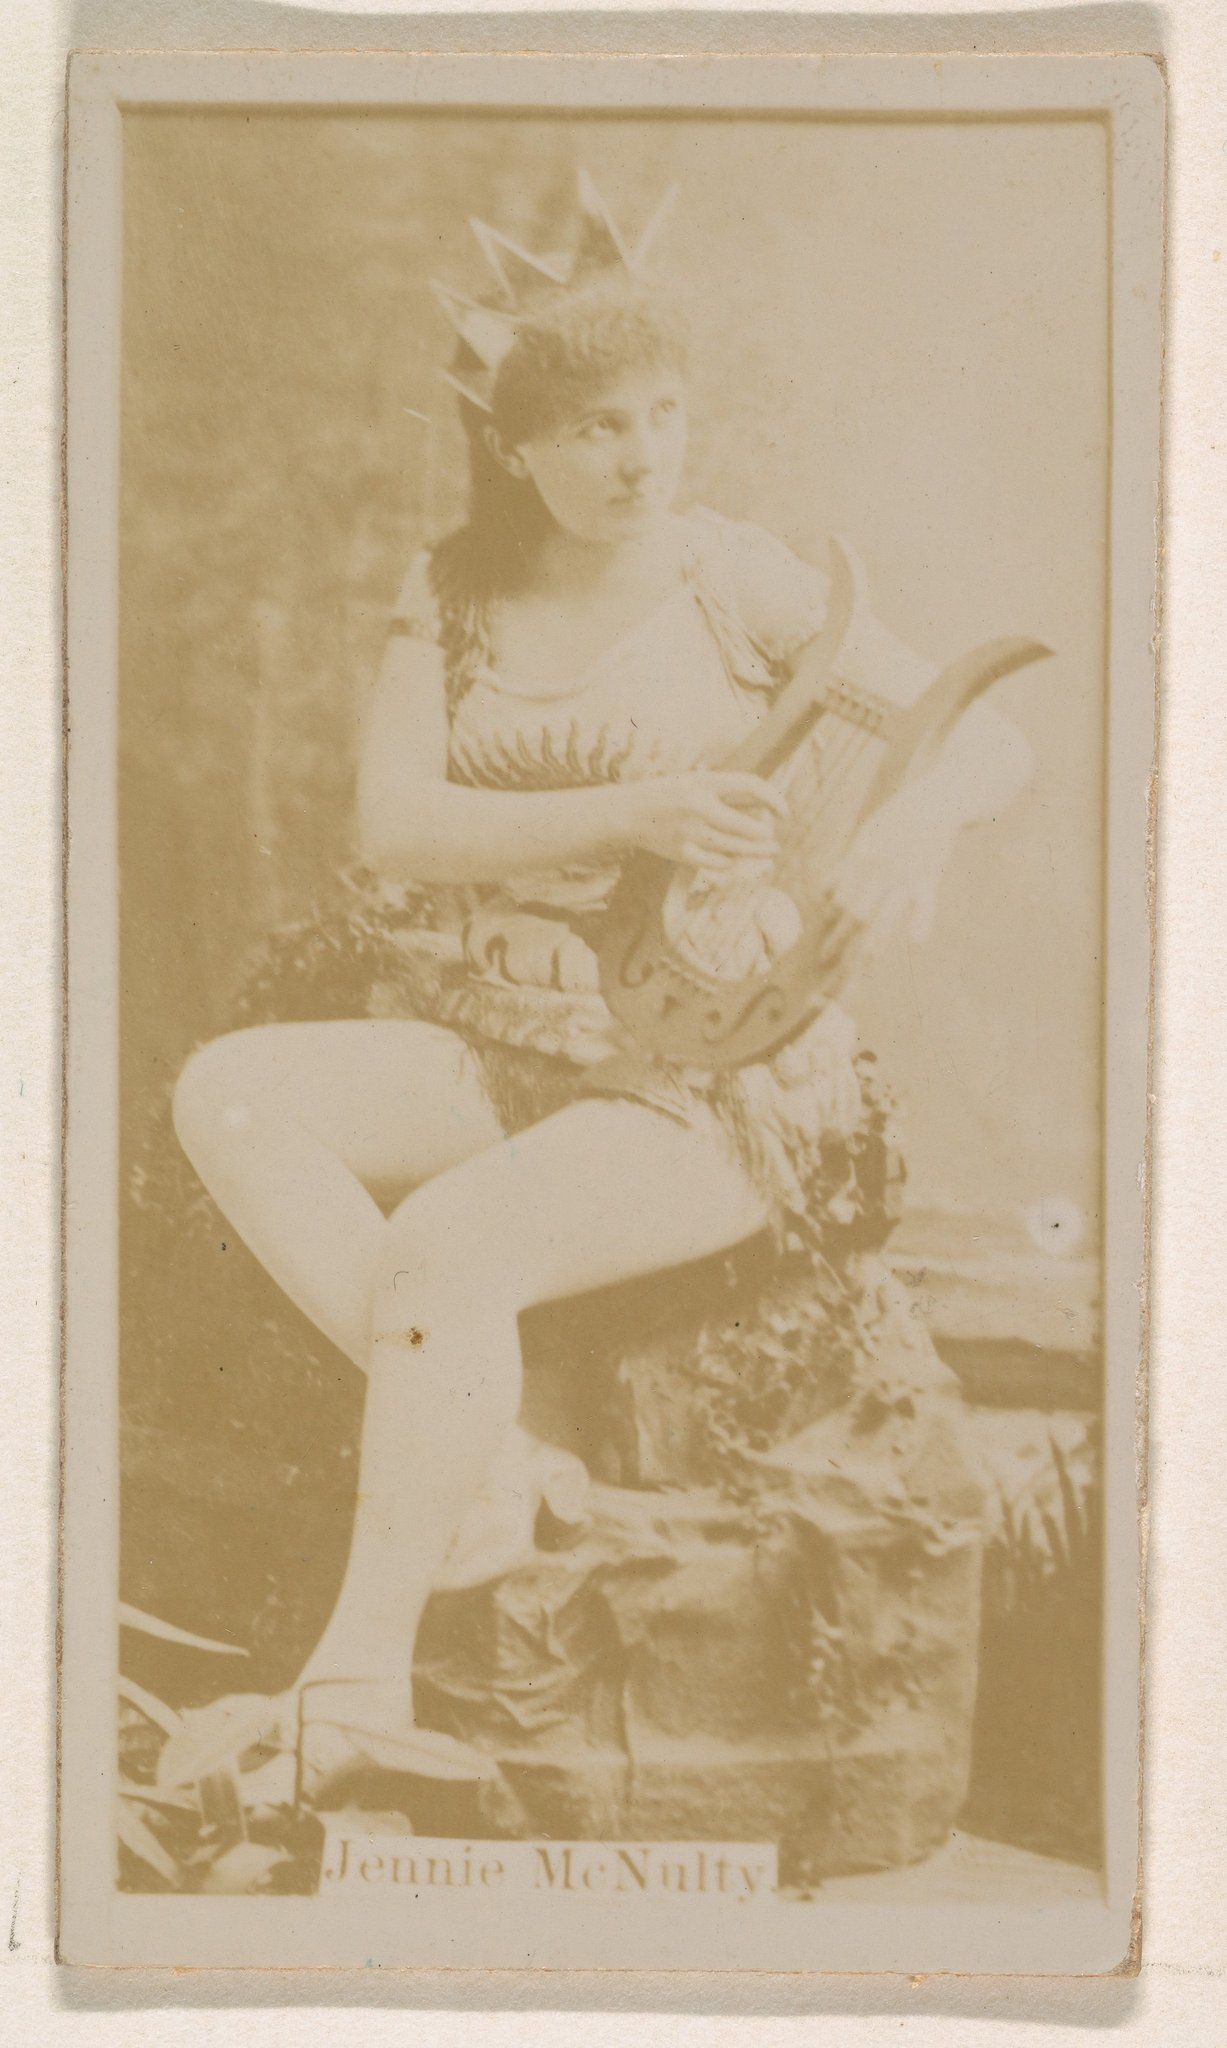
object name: photograph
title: Jennie McNulty, from the Actresses series (N245) issued by Kinney Brothers to promote Sweet Caporal Cigarettes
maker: kinney brothers tobacco company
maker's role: publisher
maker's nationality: american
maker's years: 1869-2011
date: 1890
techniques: albumen silver print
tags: portraits,women,actresses